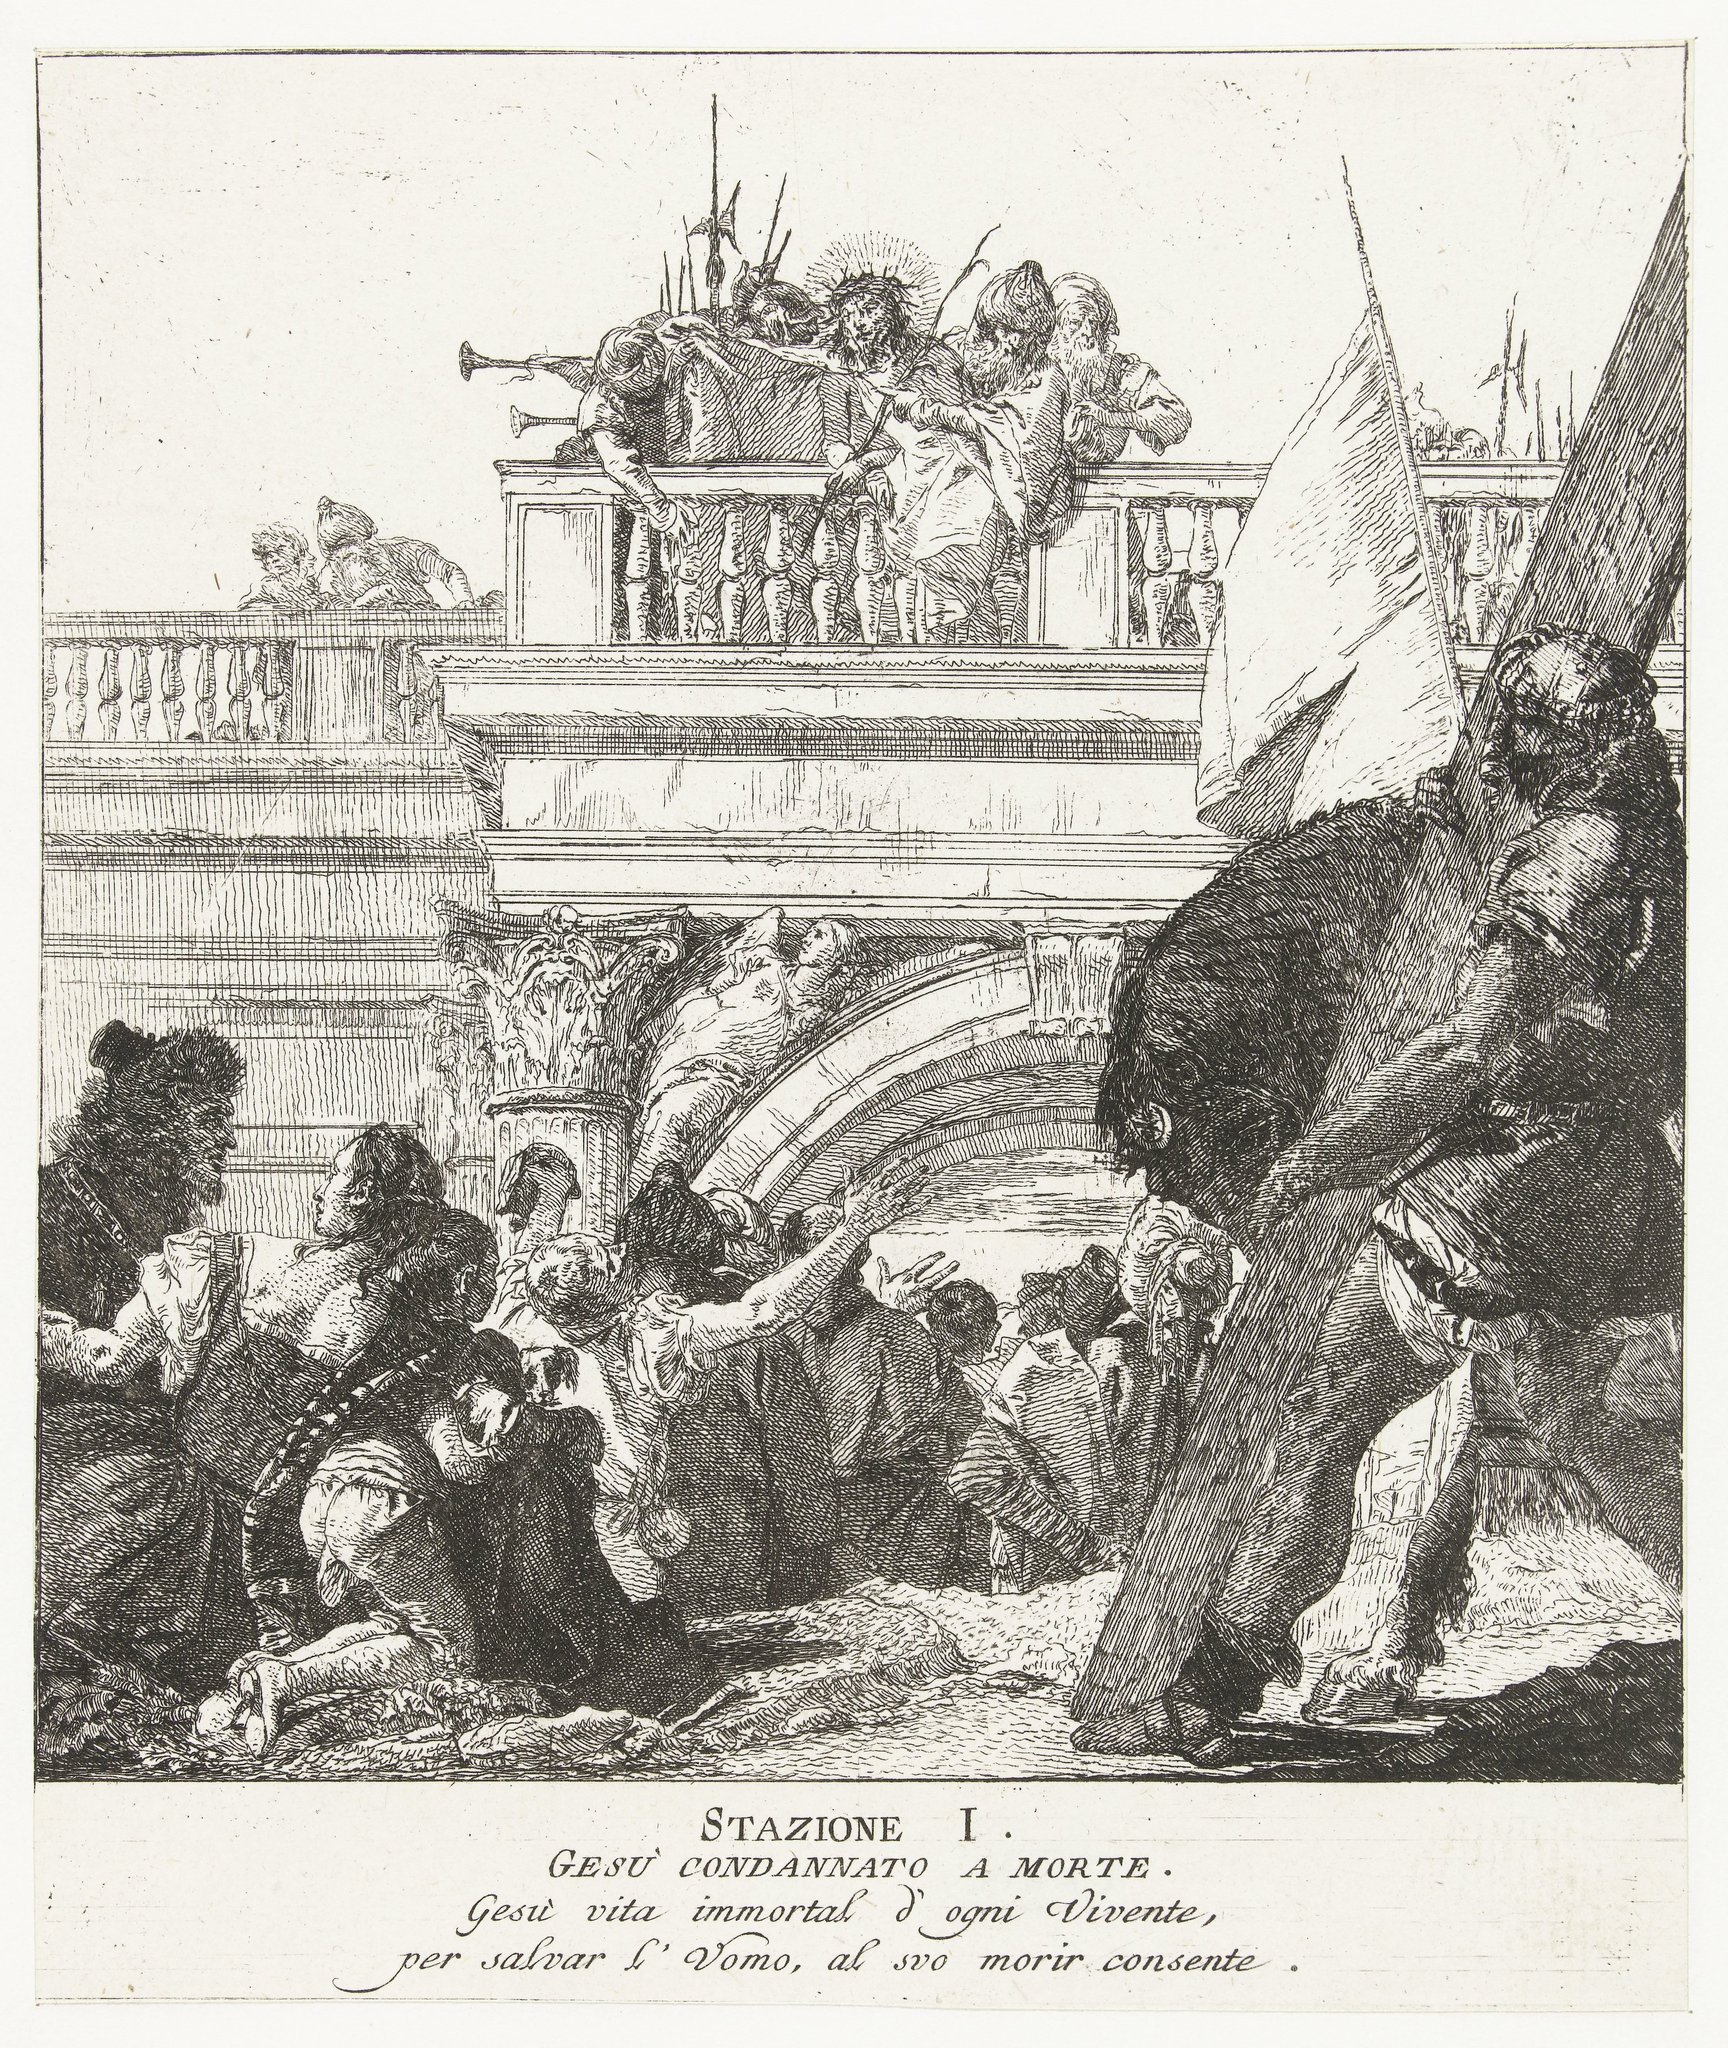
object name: print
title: Stazione I Gesu condannato a morte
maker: giovanni domenico tiepolo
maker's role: draughtsman, print maker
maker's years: 1727-1804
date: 1747-1749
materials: paper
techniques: engraving, etching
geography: venice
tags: pilate showing christ to the people, 'ostentatio christi', 'ecce homo' (john 19:4-6)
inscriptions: collector's mark: Lugt 2228, collector's mark: Lugt 2760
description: Prent uit serie Kruiswegstaties of Via Crucis met zestien prenten. Giovanni Domenico Tiepolo vervaardigde de etsen naar de schilderijen met Kruiswegstaties in het Oratorio del Crocefisso in de kerk San Polo te Venetië.